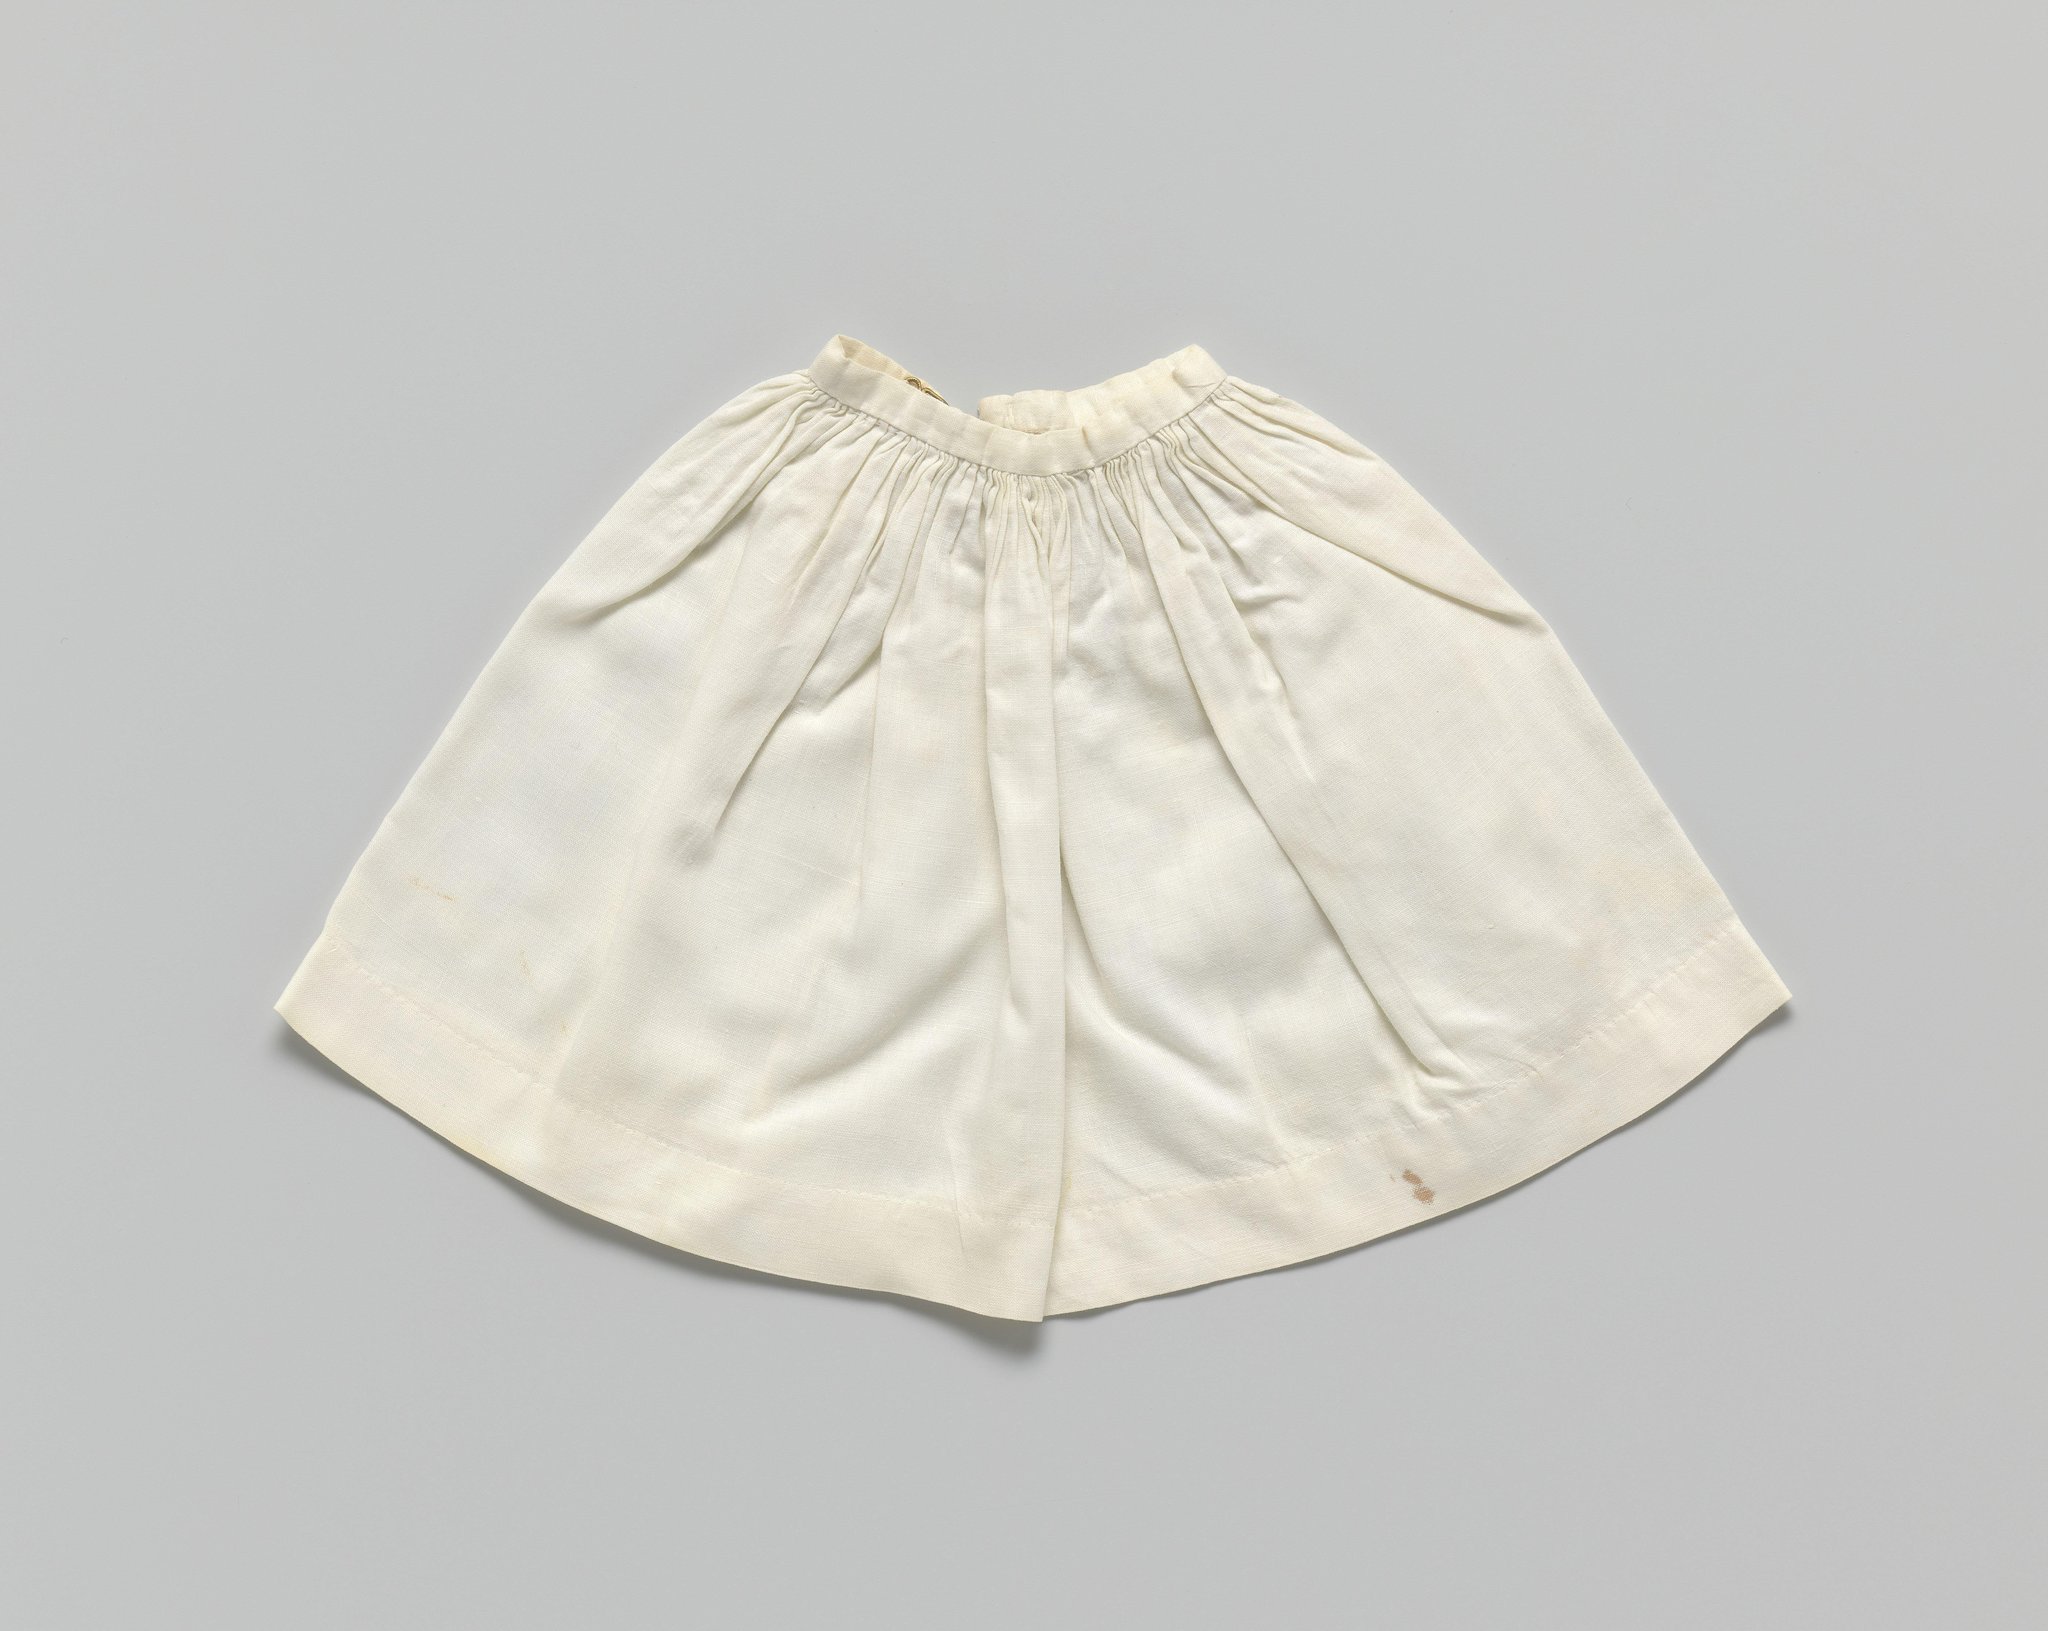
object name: underskirt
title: Onderrok van wit katoen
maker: Anonymous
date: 1850-1920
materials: cotton, metal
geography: europe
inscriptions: number: ‘RBK15445’